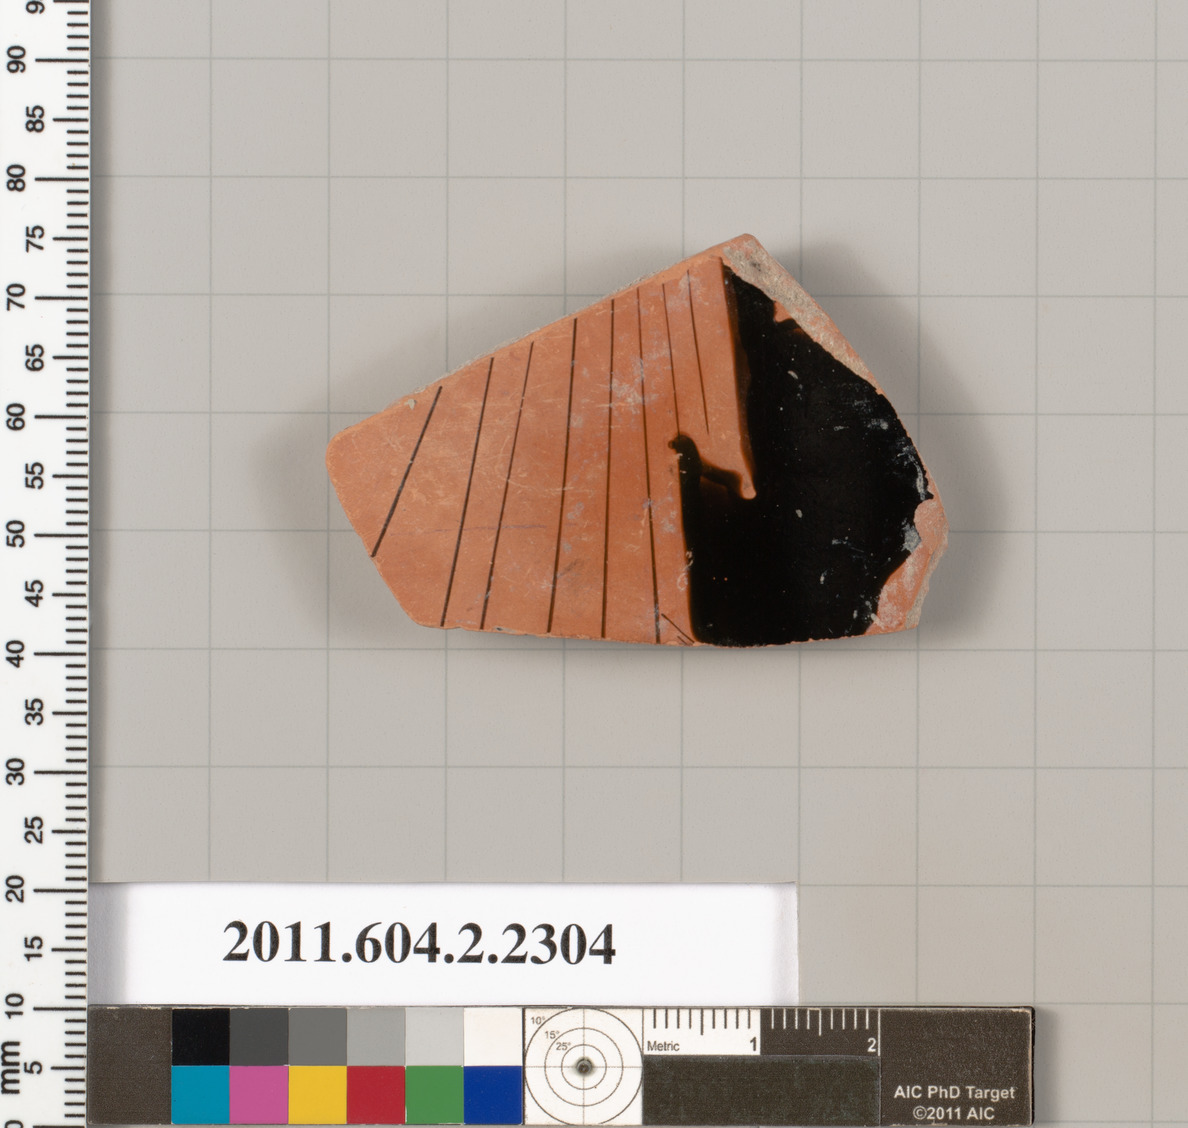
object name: krater fragment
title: Terracotta fragment of a krater (bowl for mixing wine and water)?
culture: greek, attic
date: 460-440 BCE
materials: terracotta